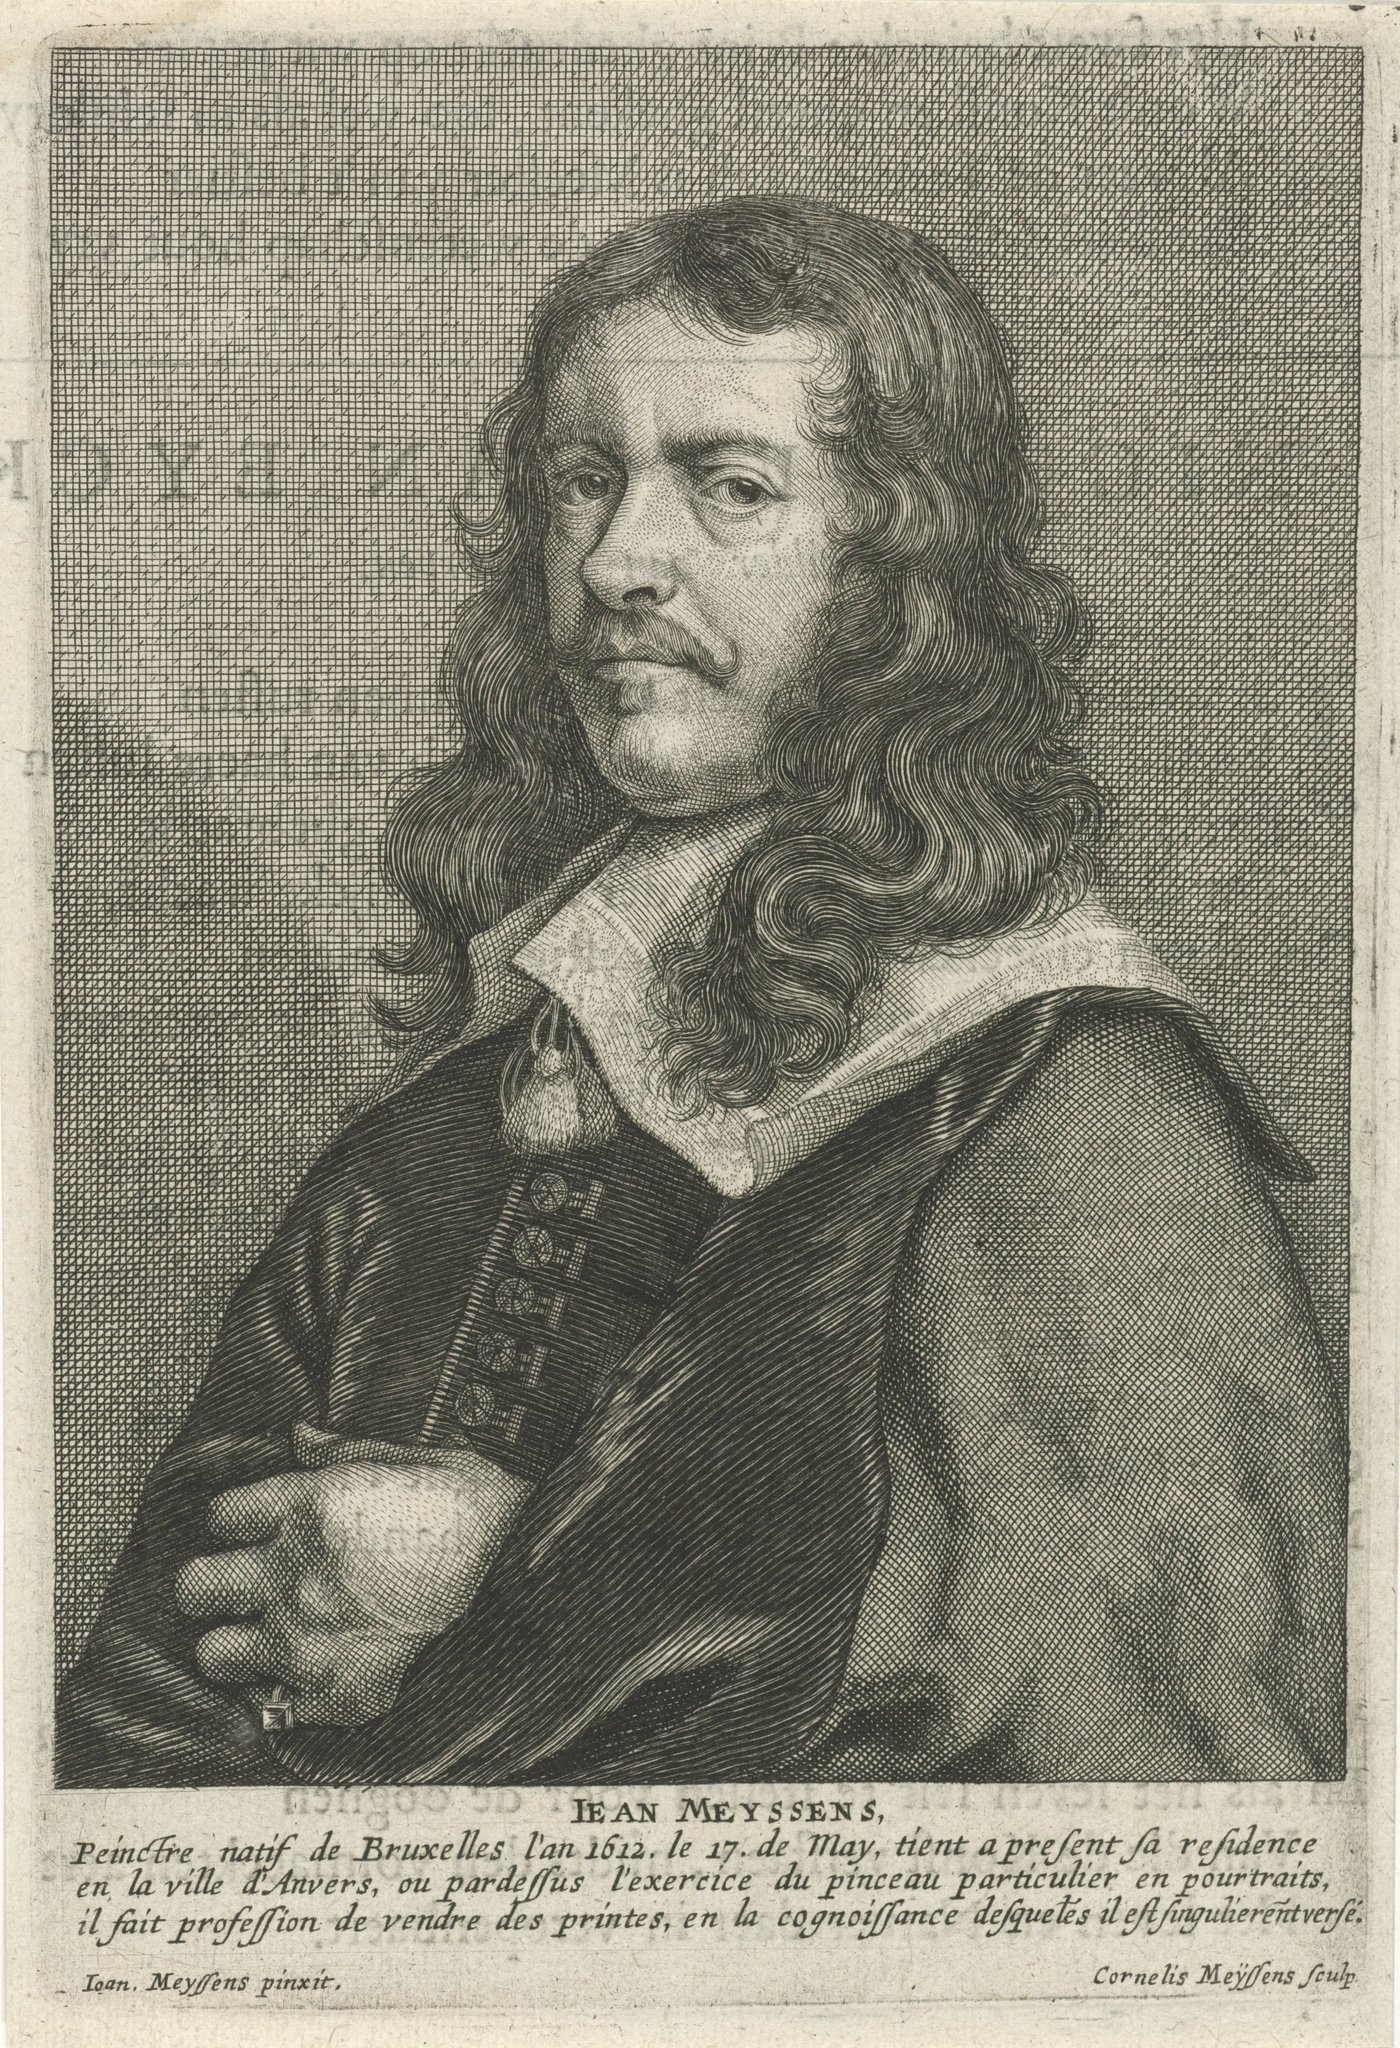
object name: book illustration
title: Portret van Joannes Meyssens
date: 1662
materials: paper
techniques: engraving, letterpress printing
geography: antwerp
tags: brussels, antwerp, print maker, publisher, joannes meyssens, portrait, self-portrait of artist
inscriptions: collector's mark: Lugt 2228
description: Prent uit: Bie, Cornelis de. Het gulden cabinet vande edele vry schilder-const. 3 dln. Antwerpen: Joannes Meyssens en Juliaen van Montfort, 1662, dl. 2.